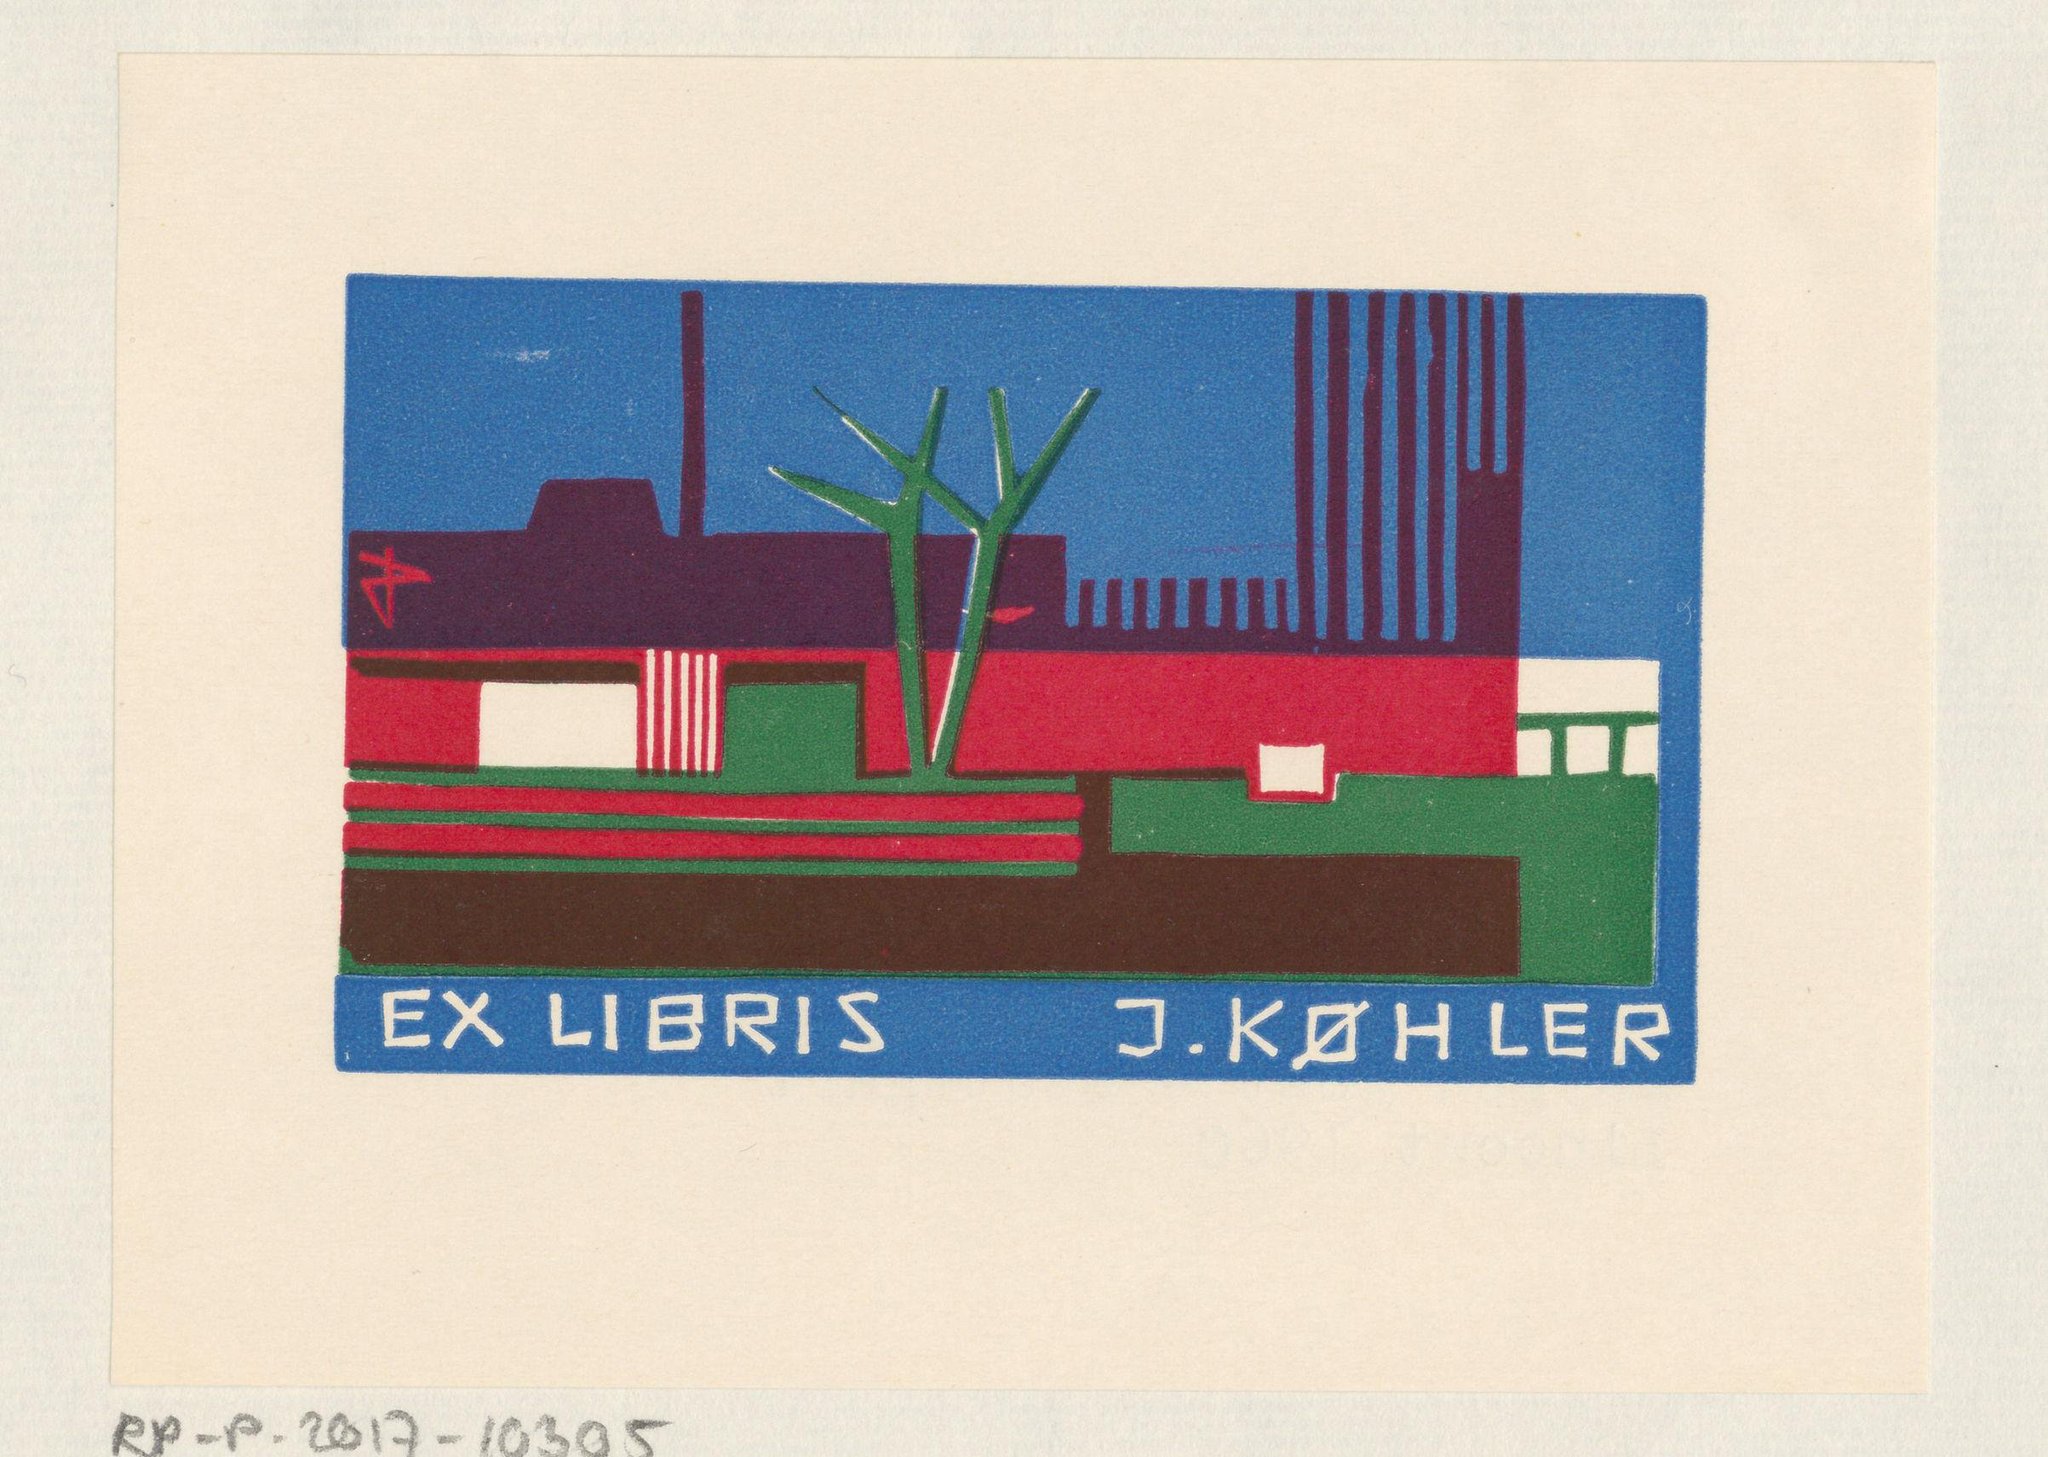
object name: bookplate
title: Ex libris J. Køhler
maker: jürgen dost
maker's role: print maker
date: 1960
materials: paper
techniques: linocut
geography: stuttgart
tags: trees, housing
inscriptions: workshop stamp: ‘Jürgen Dost - Stuttgart/ Linocut 1960’